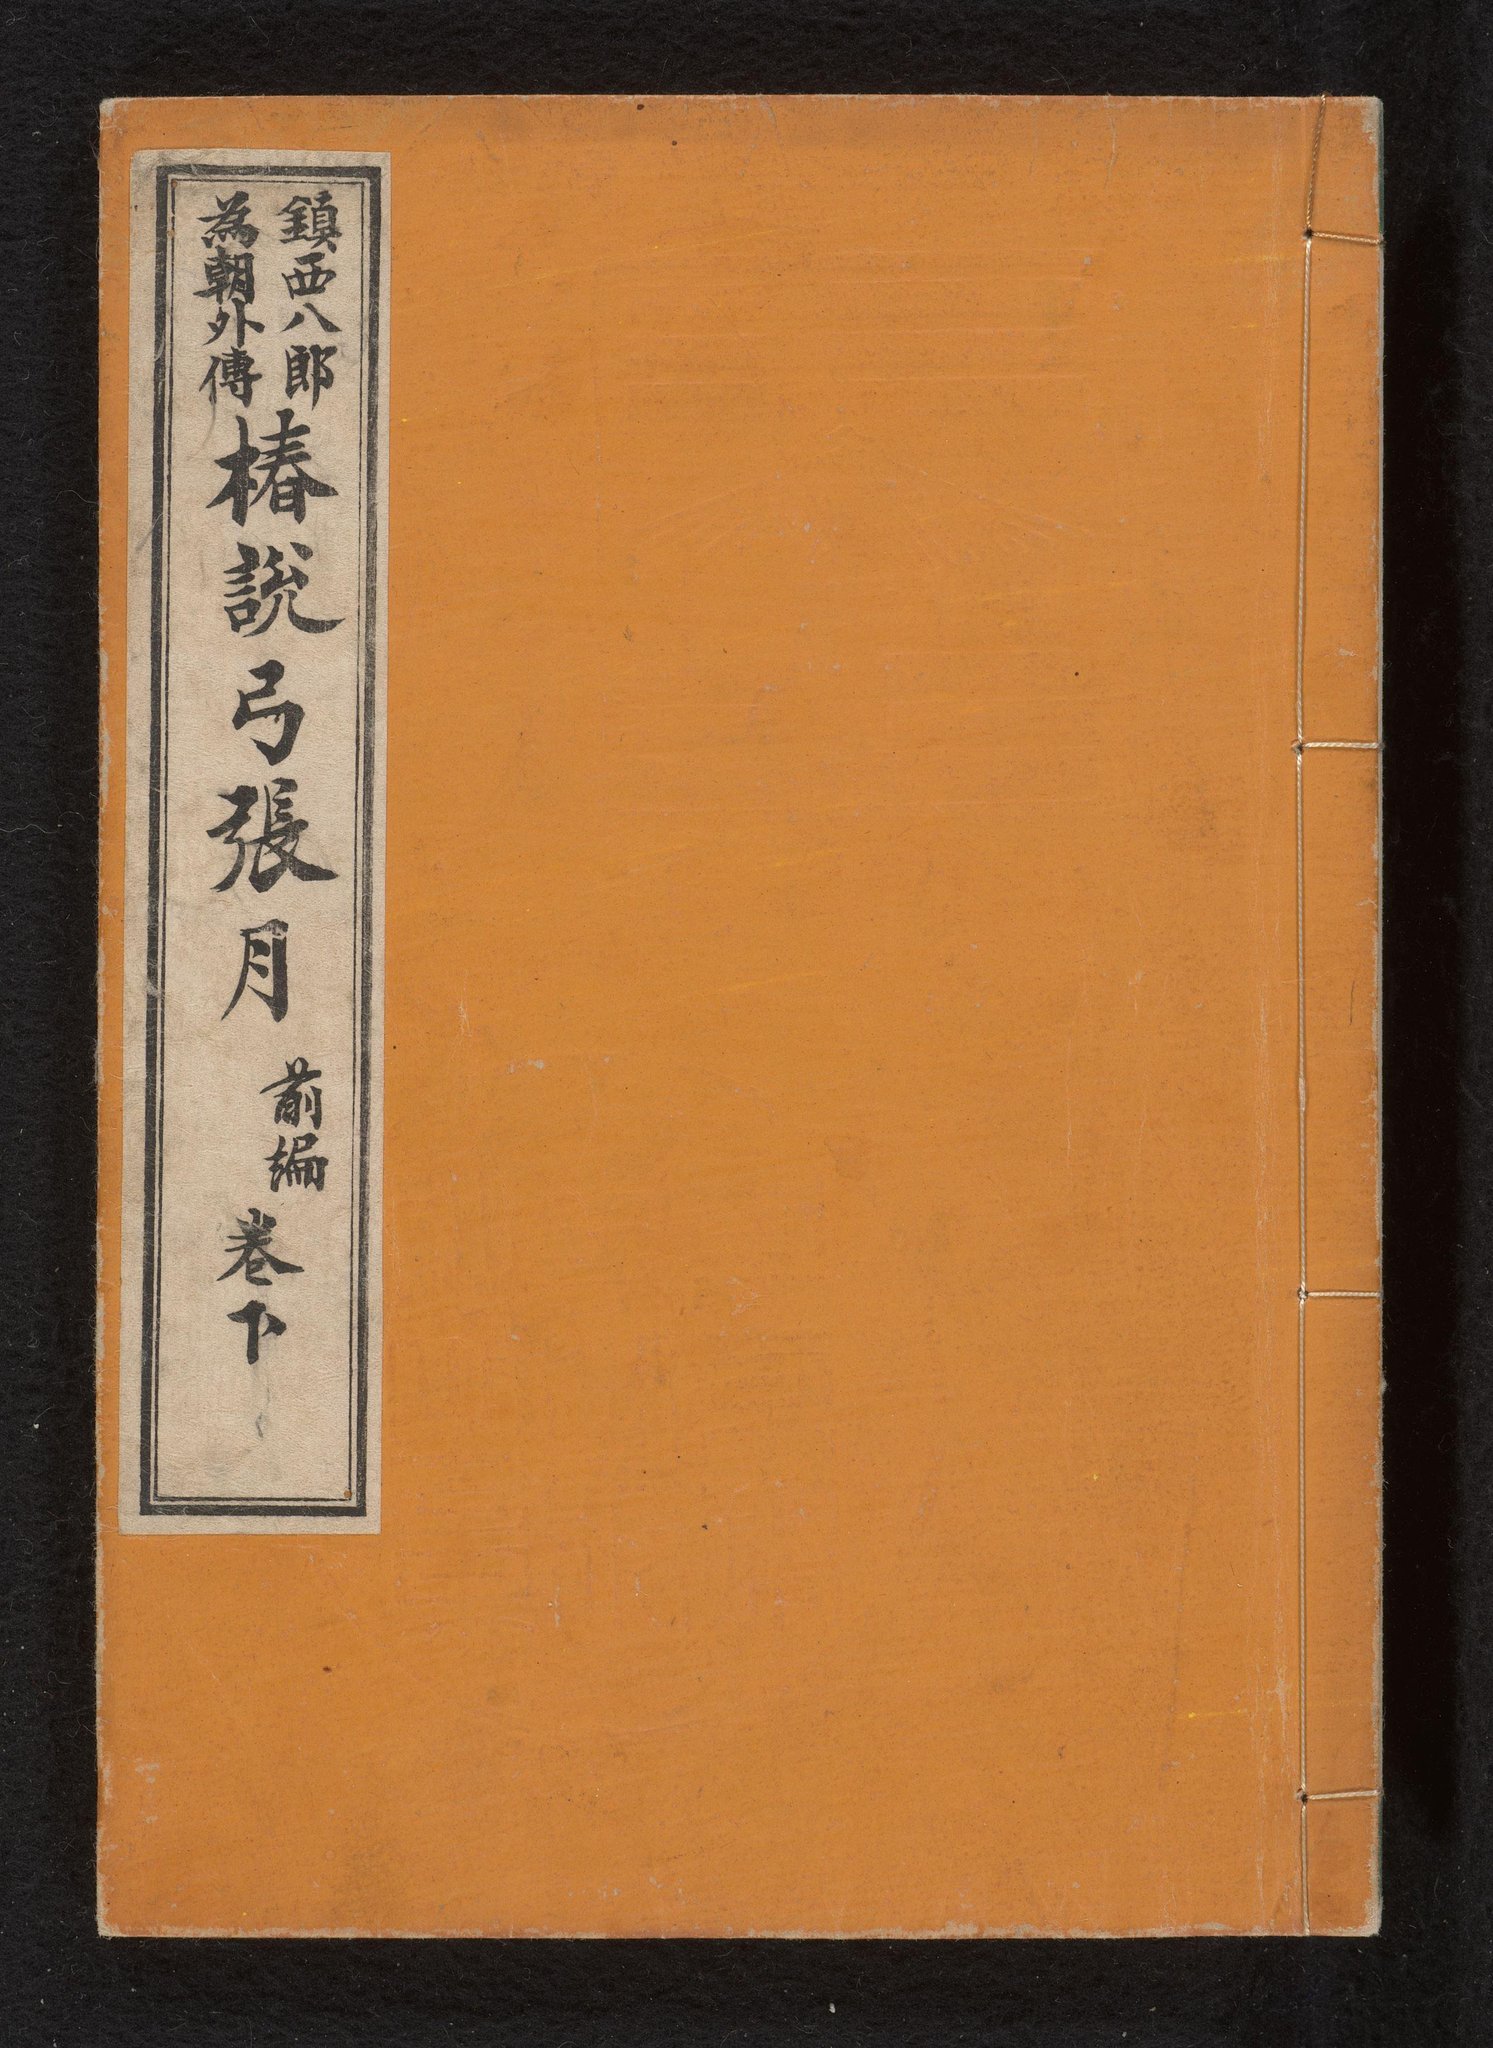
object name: book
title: De avonturen van Tametomo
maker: tsukioka yoshitoshi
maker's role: print maker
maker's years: 1839-1892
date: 1883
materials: paper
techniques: blind stamped, lithograph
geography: japan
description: Boek uit een tiendelige serie over de avonturen van de legendarische strijder Tametomo, geïllustreerd met 26 prenten gesigneerd door Tsukioka Yoshitoshi. De prenten zijn uitgevoerd in een combinatie van houtsnede en lithografie en gedrukt in zwart met een grijs toonblok. In originele banden met blinddruk.